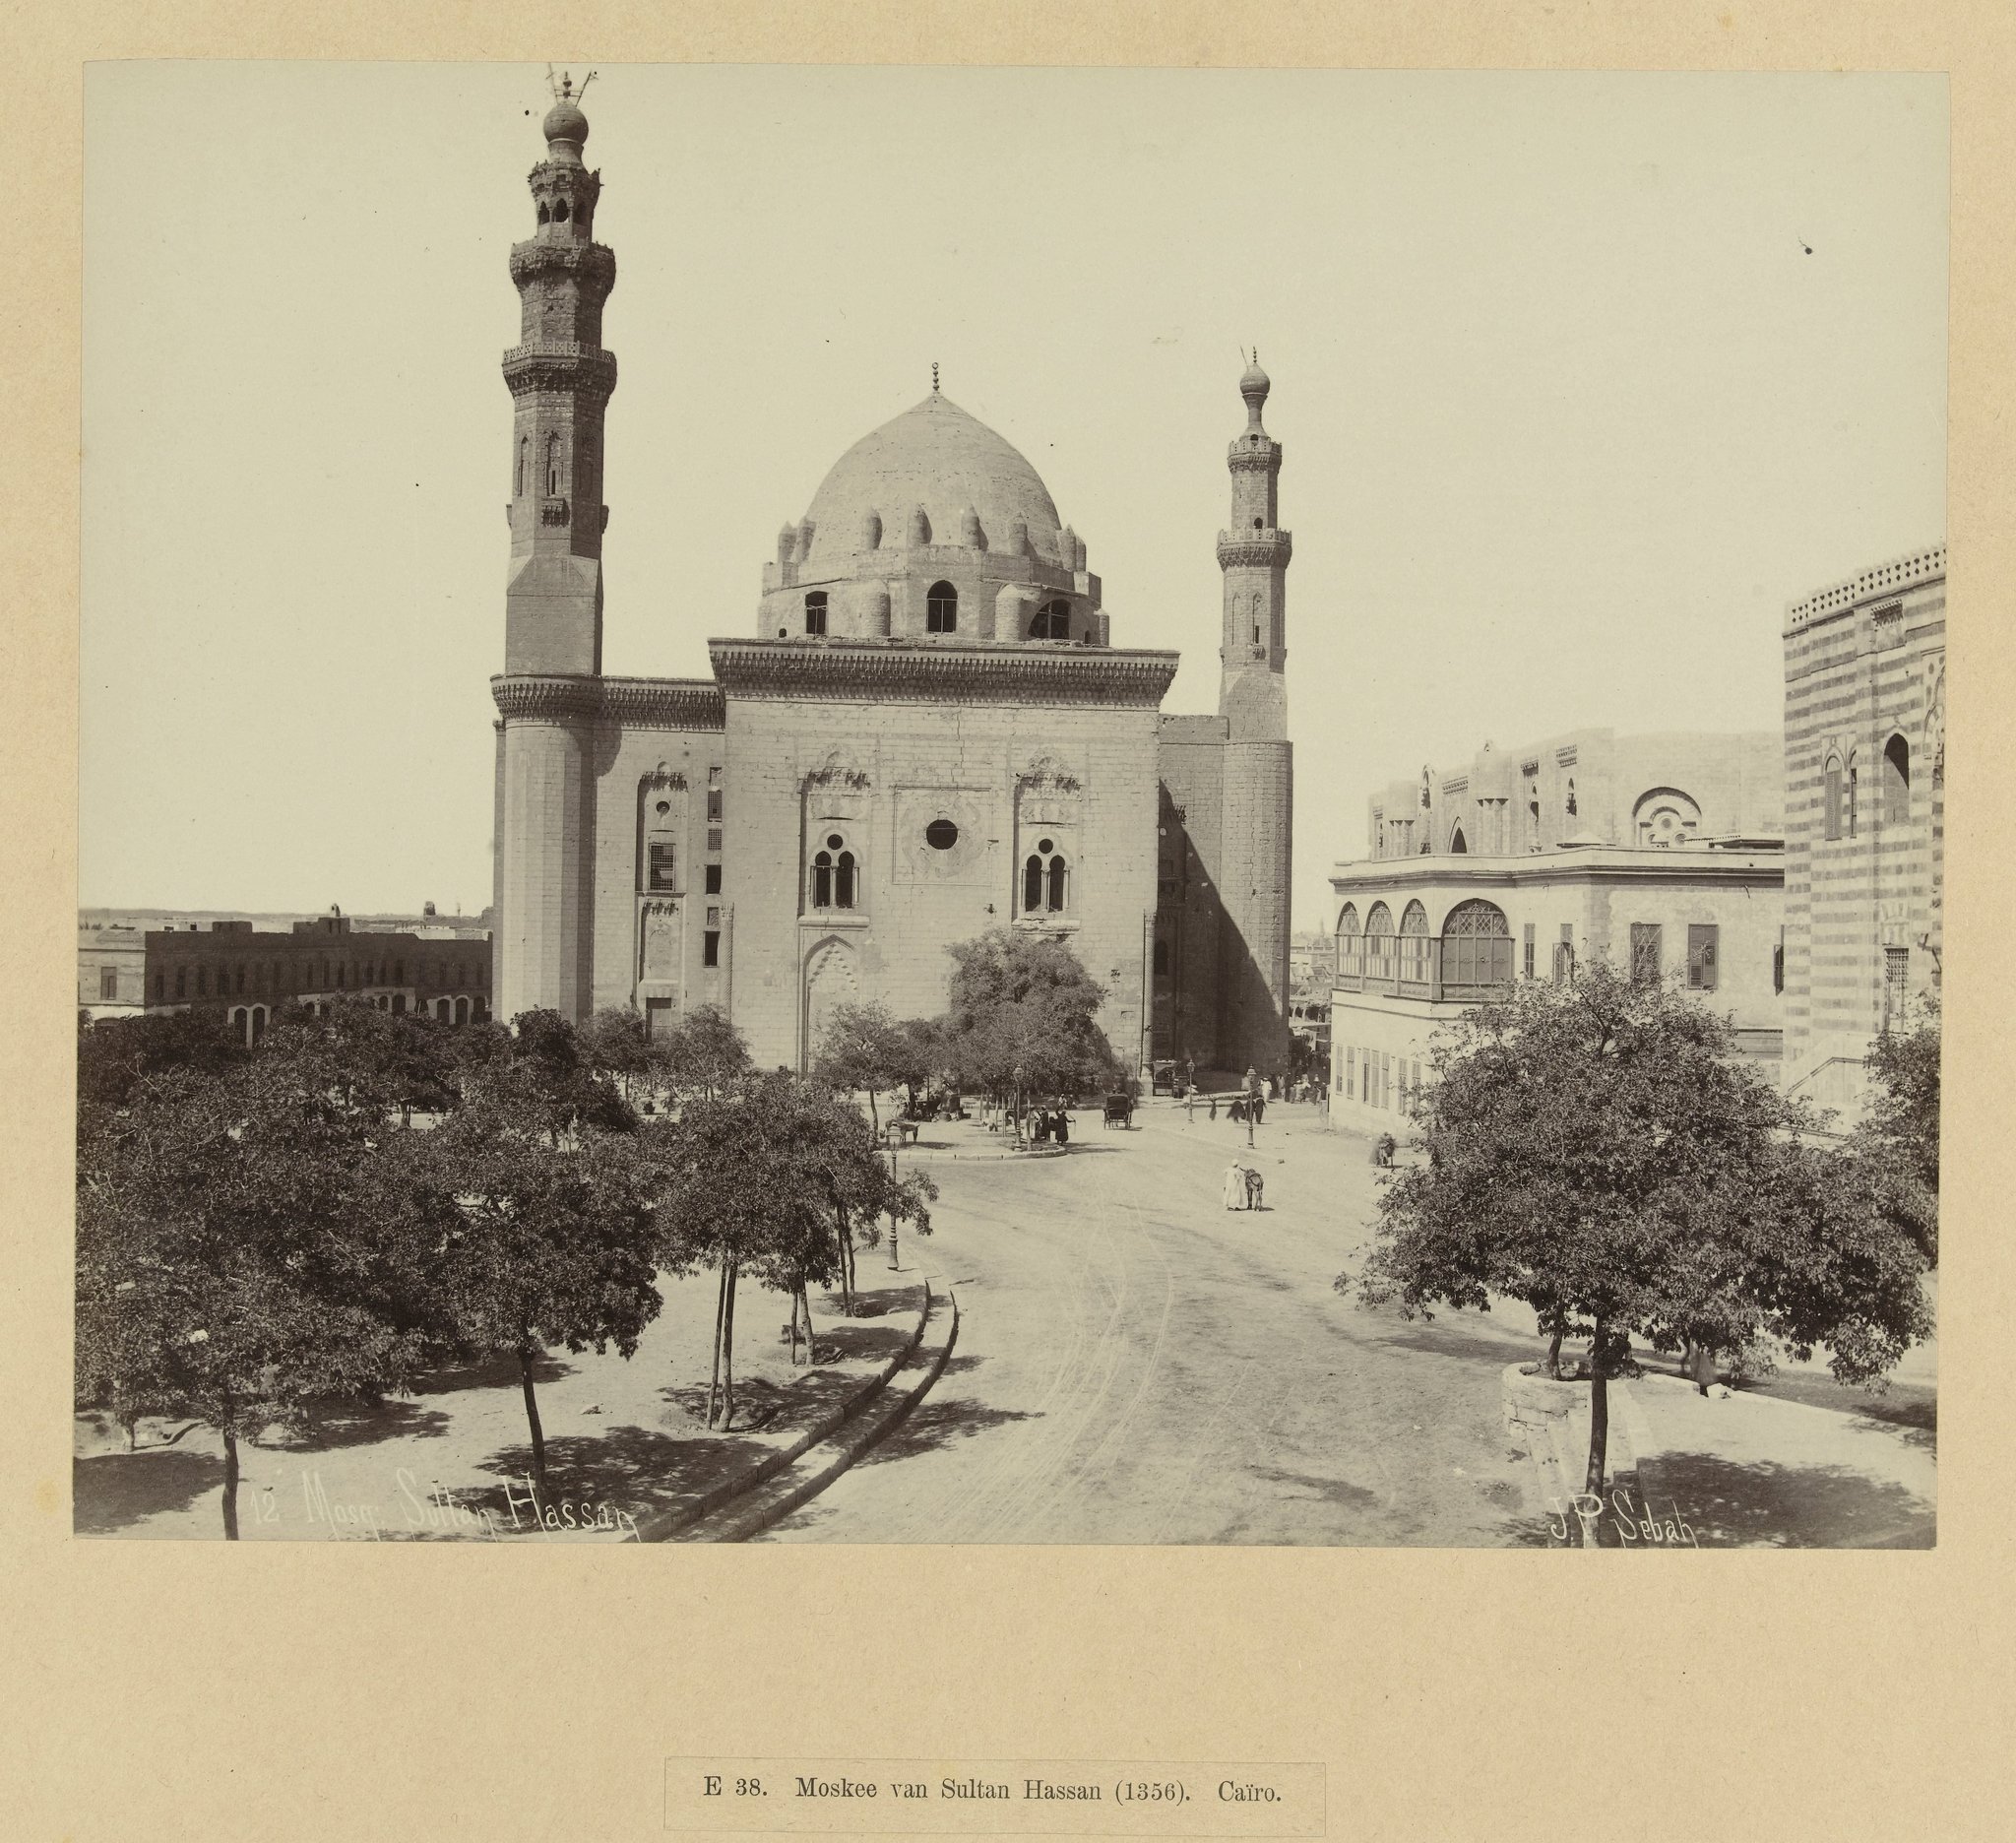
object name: photograph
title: Mosq; Sultan Hassan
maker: jean pascal sébah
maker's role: fotograaf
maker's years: 1872-1947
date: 1888-1895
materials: cardboard, paper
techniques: albumen print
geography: cairo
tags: temple, shrine ~ islam, mohammedanism, mosque-madrasa of sultan hassan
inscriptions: title: ‘E 38. Moskee van Sultan Hassan (1356). Caïro.’, number: ‘12’, stamp: ‘Gemeentelijke bibliotheek/ Rotterdam’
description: Onderdeel van een groep door fotograaf Richard Polak op reis verzamelde foto’s. Deze foto is samen met andere op zijn reizen verzamelde foto's tentoongesteld bij de Rotterdamsche Kunstkring (1895), Arti en Amicitiae te Amsterdam (1897-1898?) en Societeit 't Collegie te Kampen (datum vooralsnog onbekend).